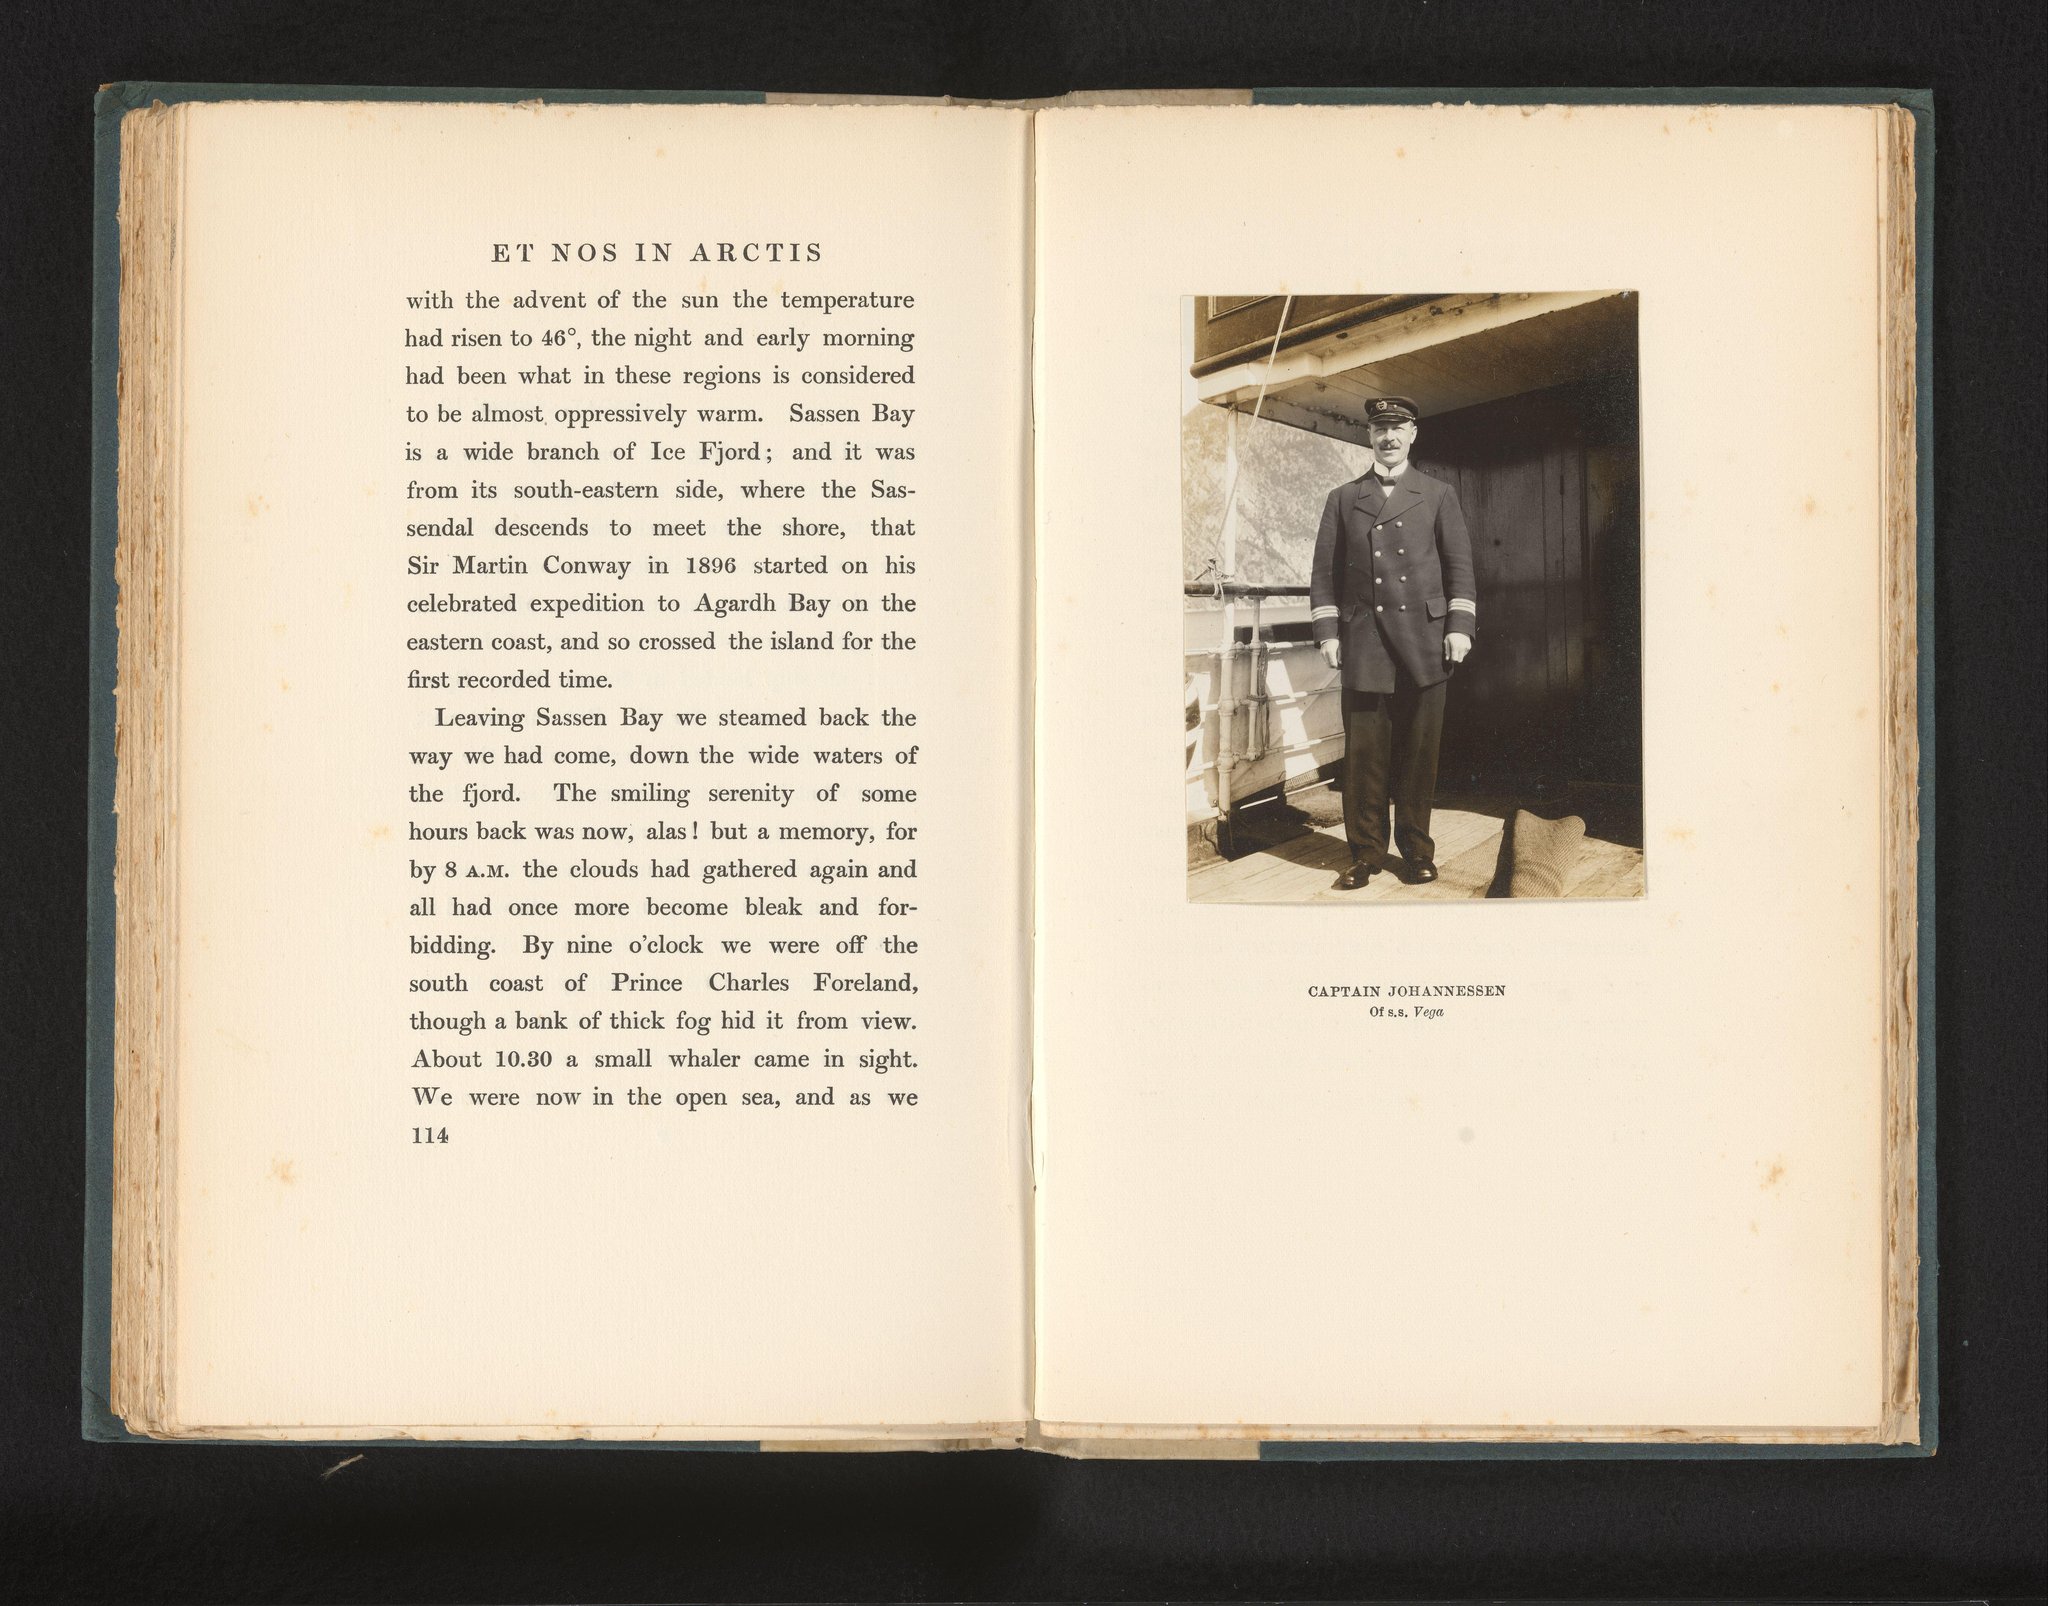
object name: page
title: Captain Johannessen of s.s. Vega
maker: Anonymous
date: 1913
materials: paper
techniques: gelatin silver print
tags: seaman (with name of rank)